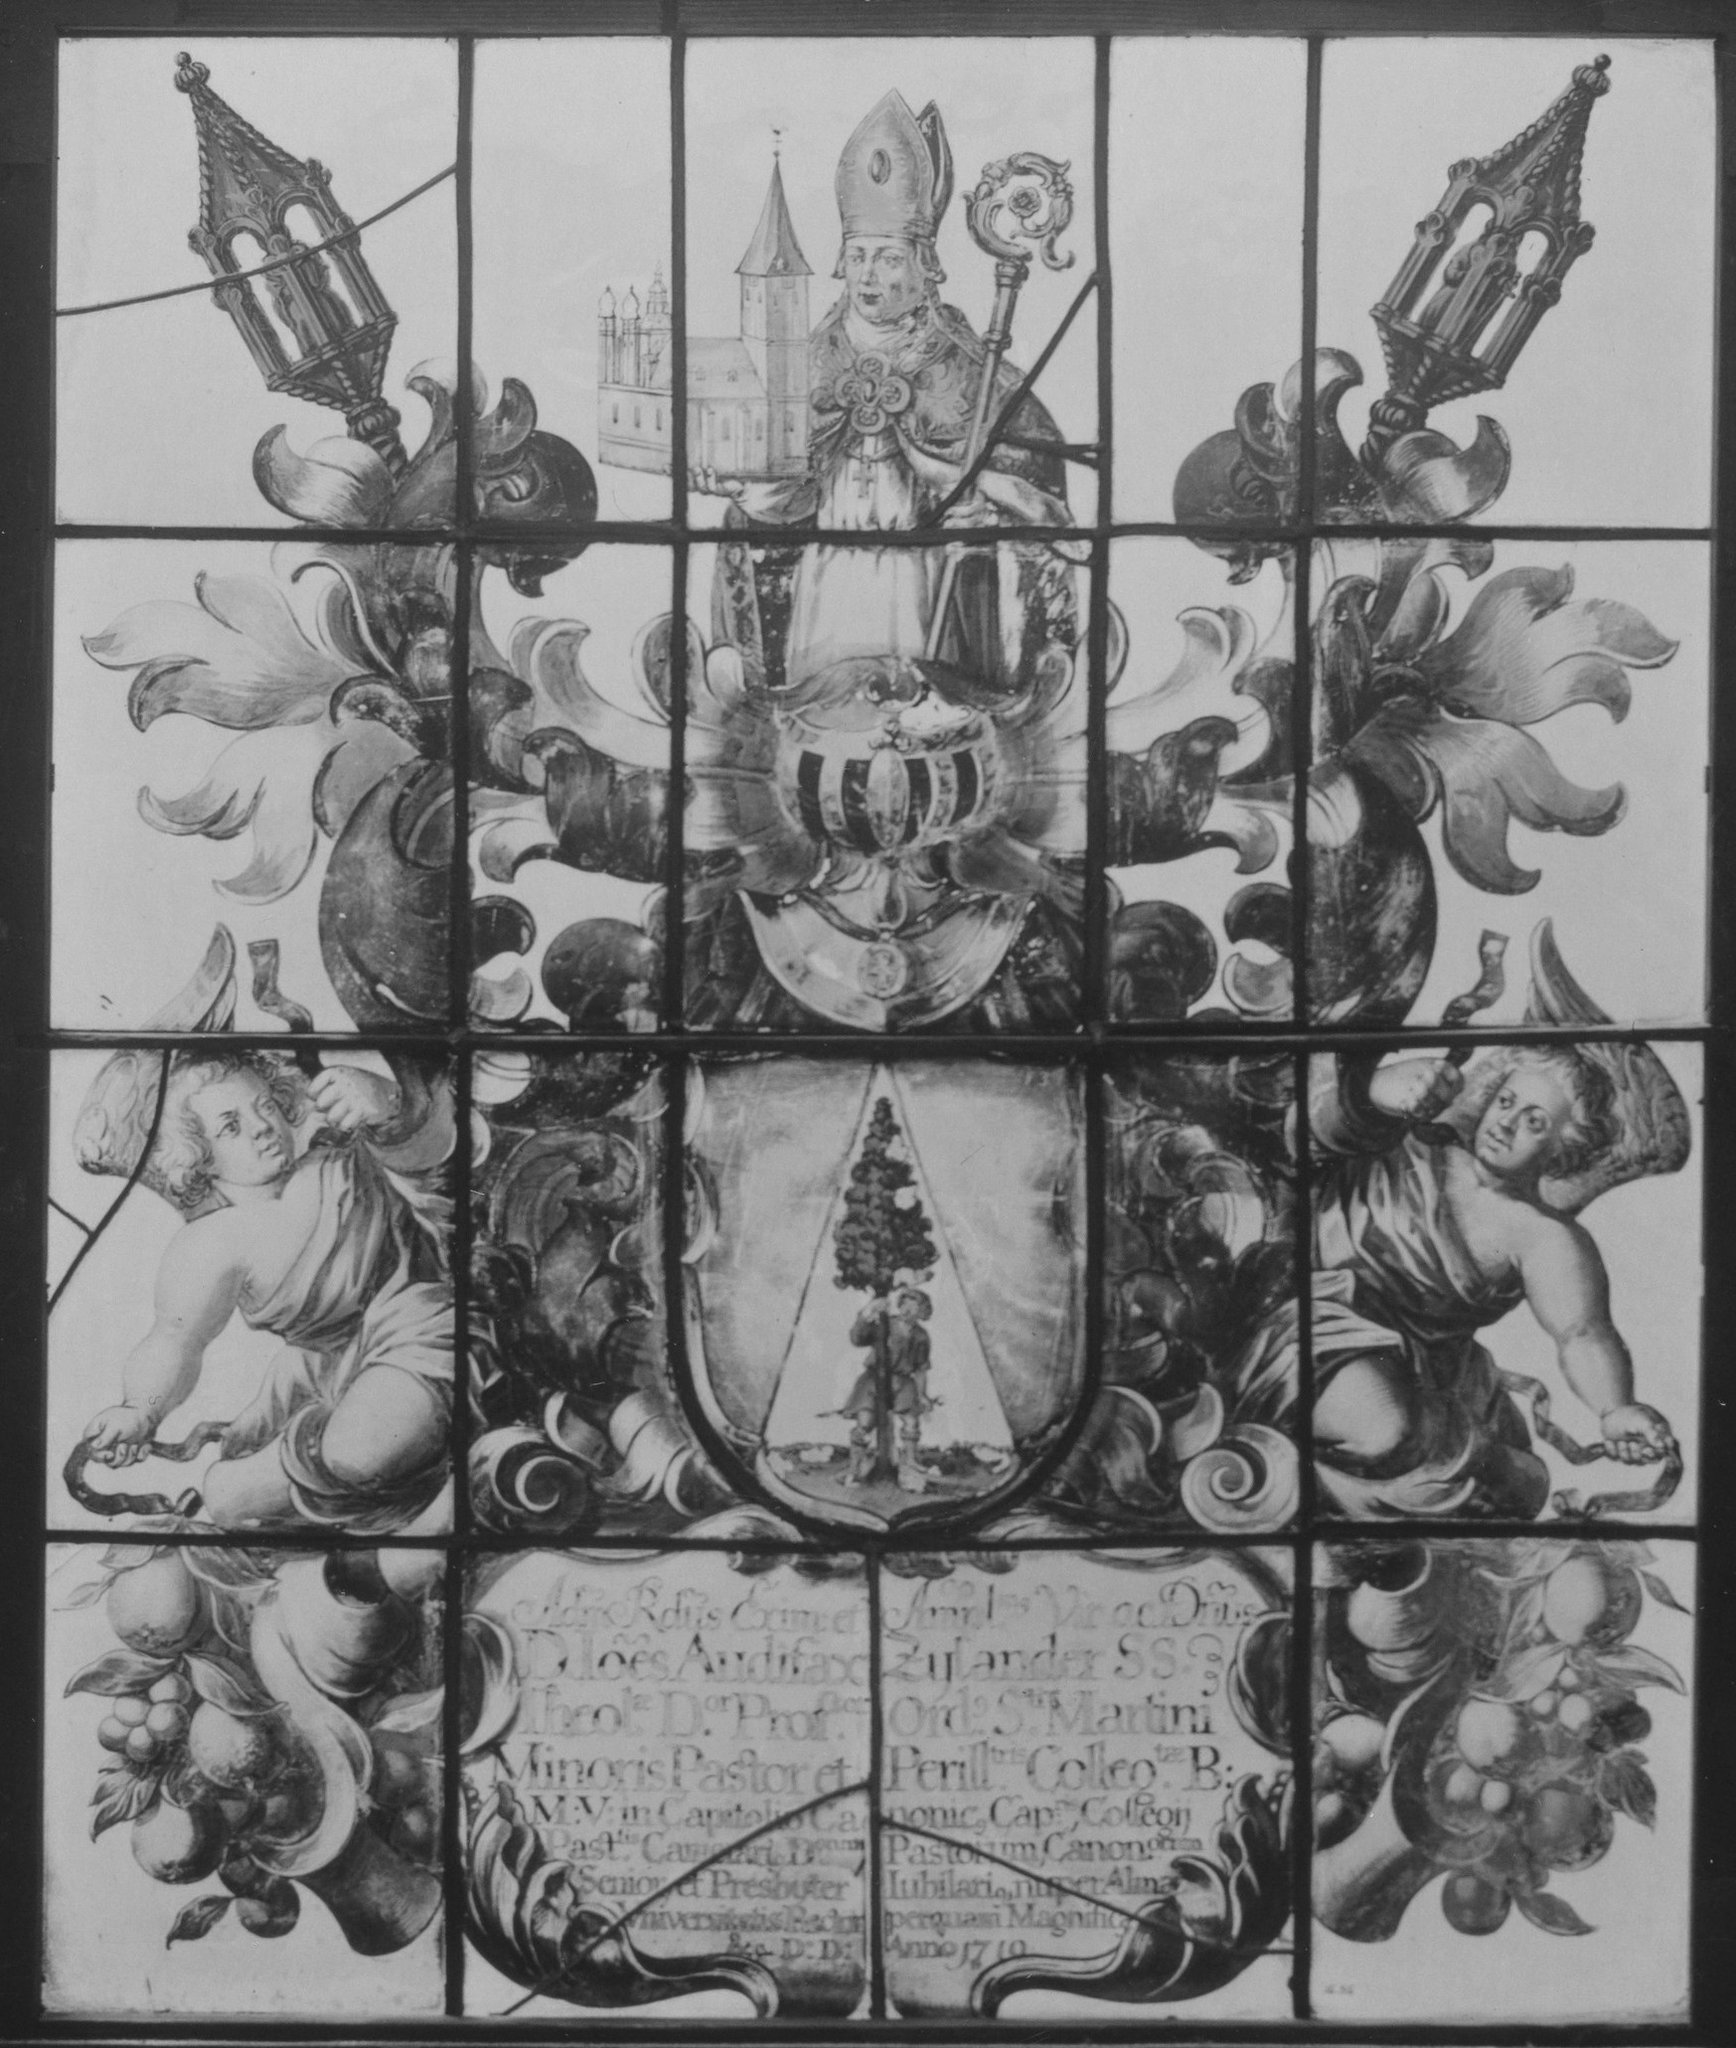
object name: armorial panel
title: Ecclesiastical armorial panel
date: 1710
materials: glass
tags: boys,men,coat of arms